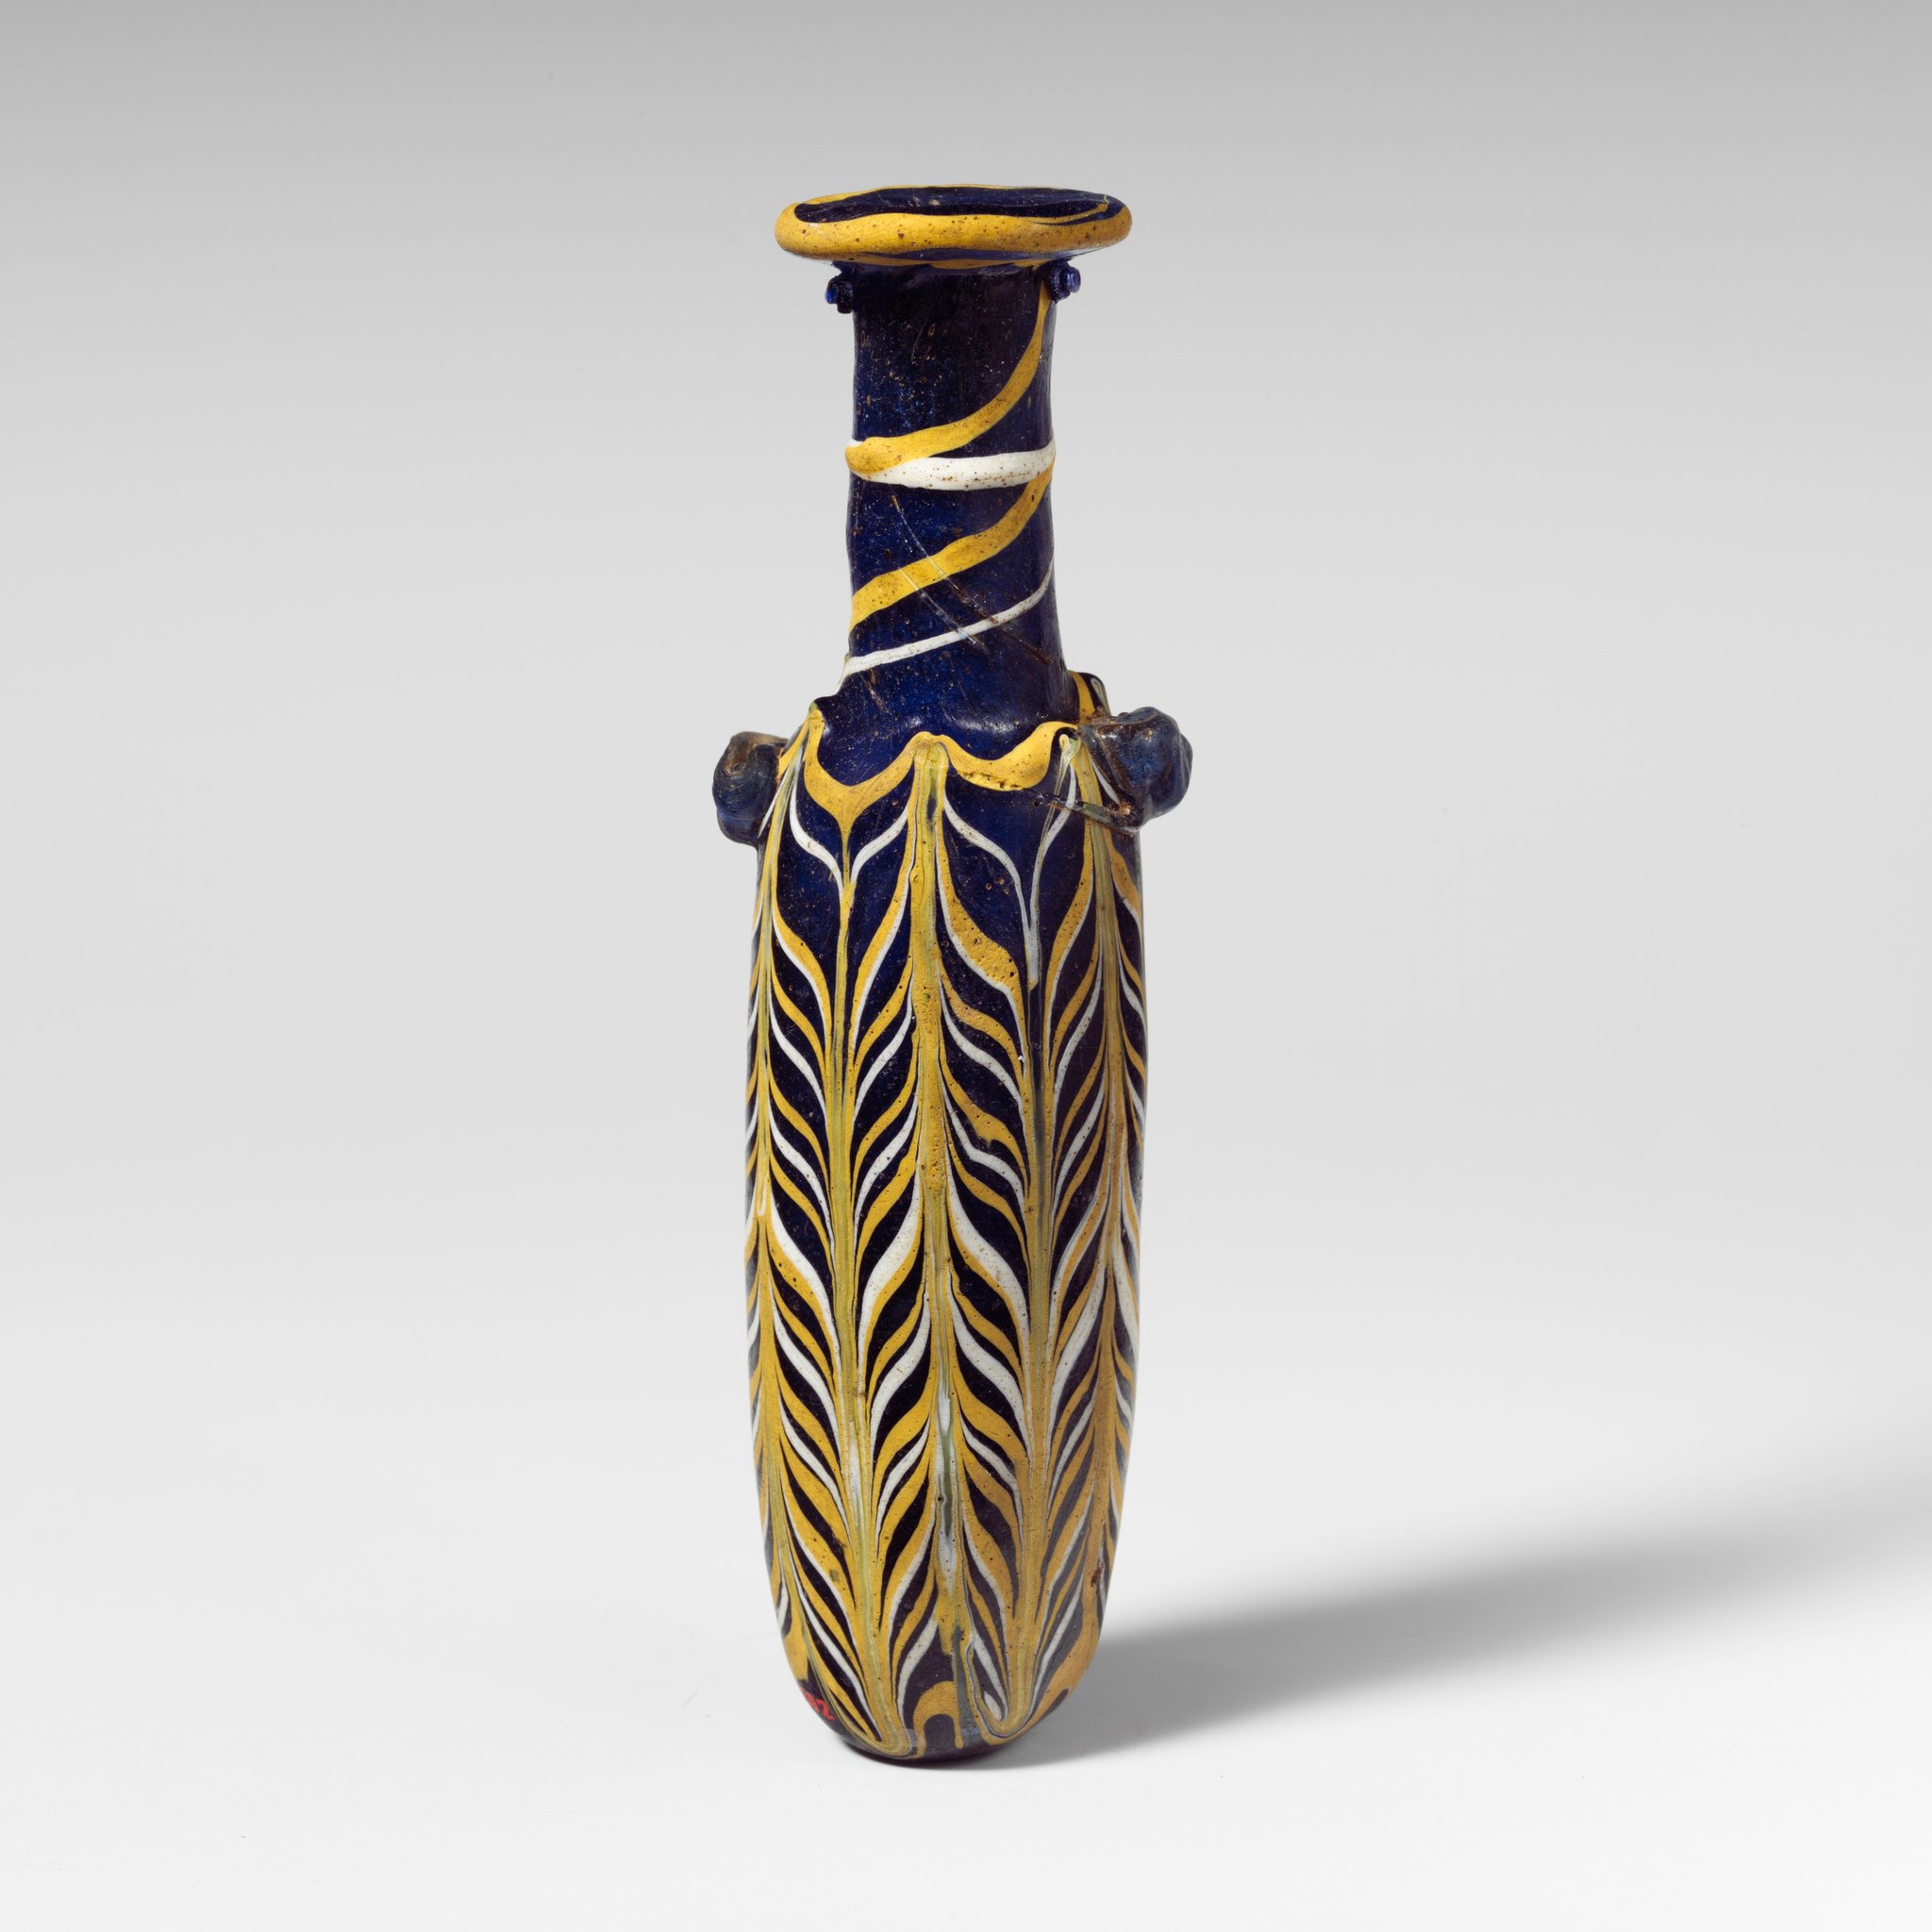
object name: alabastron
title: Glass alabastron (perfume bottle)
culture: greek, eastern mediterranean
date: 200-1 BCE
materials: glass